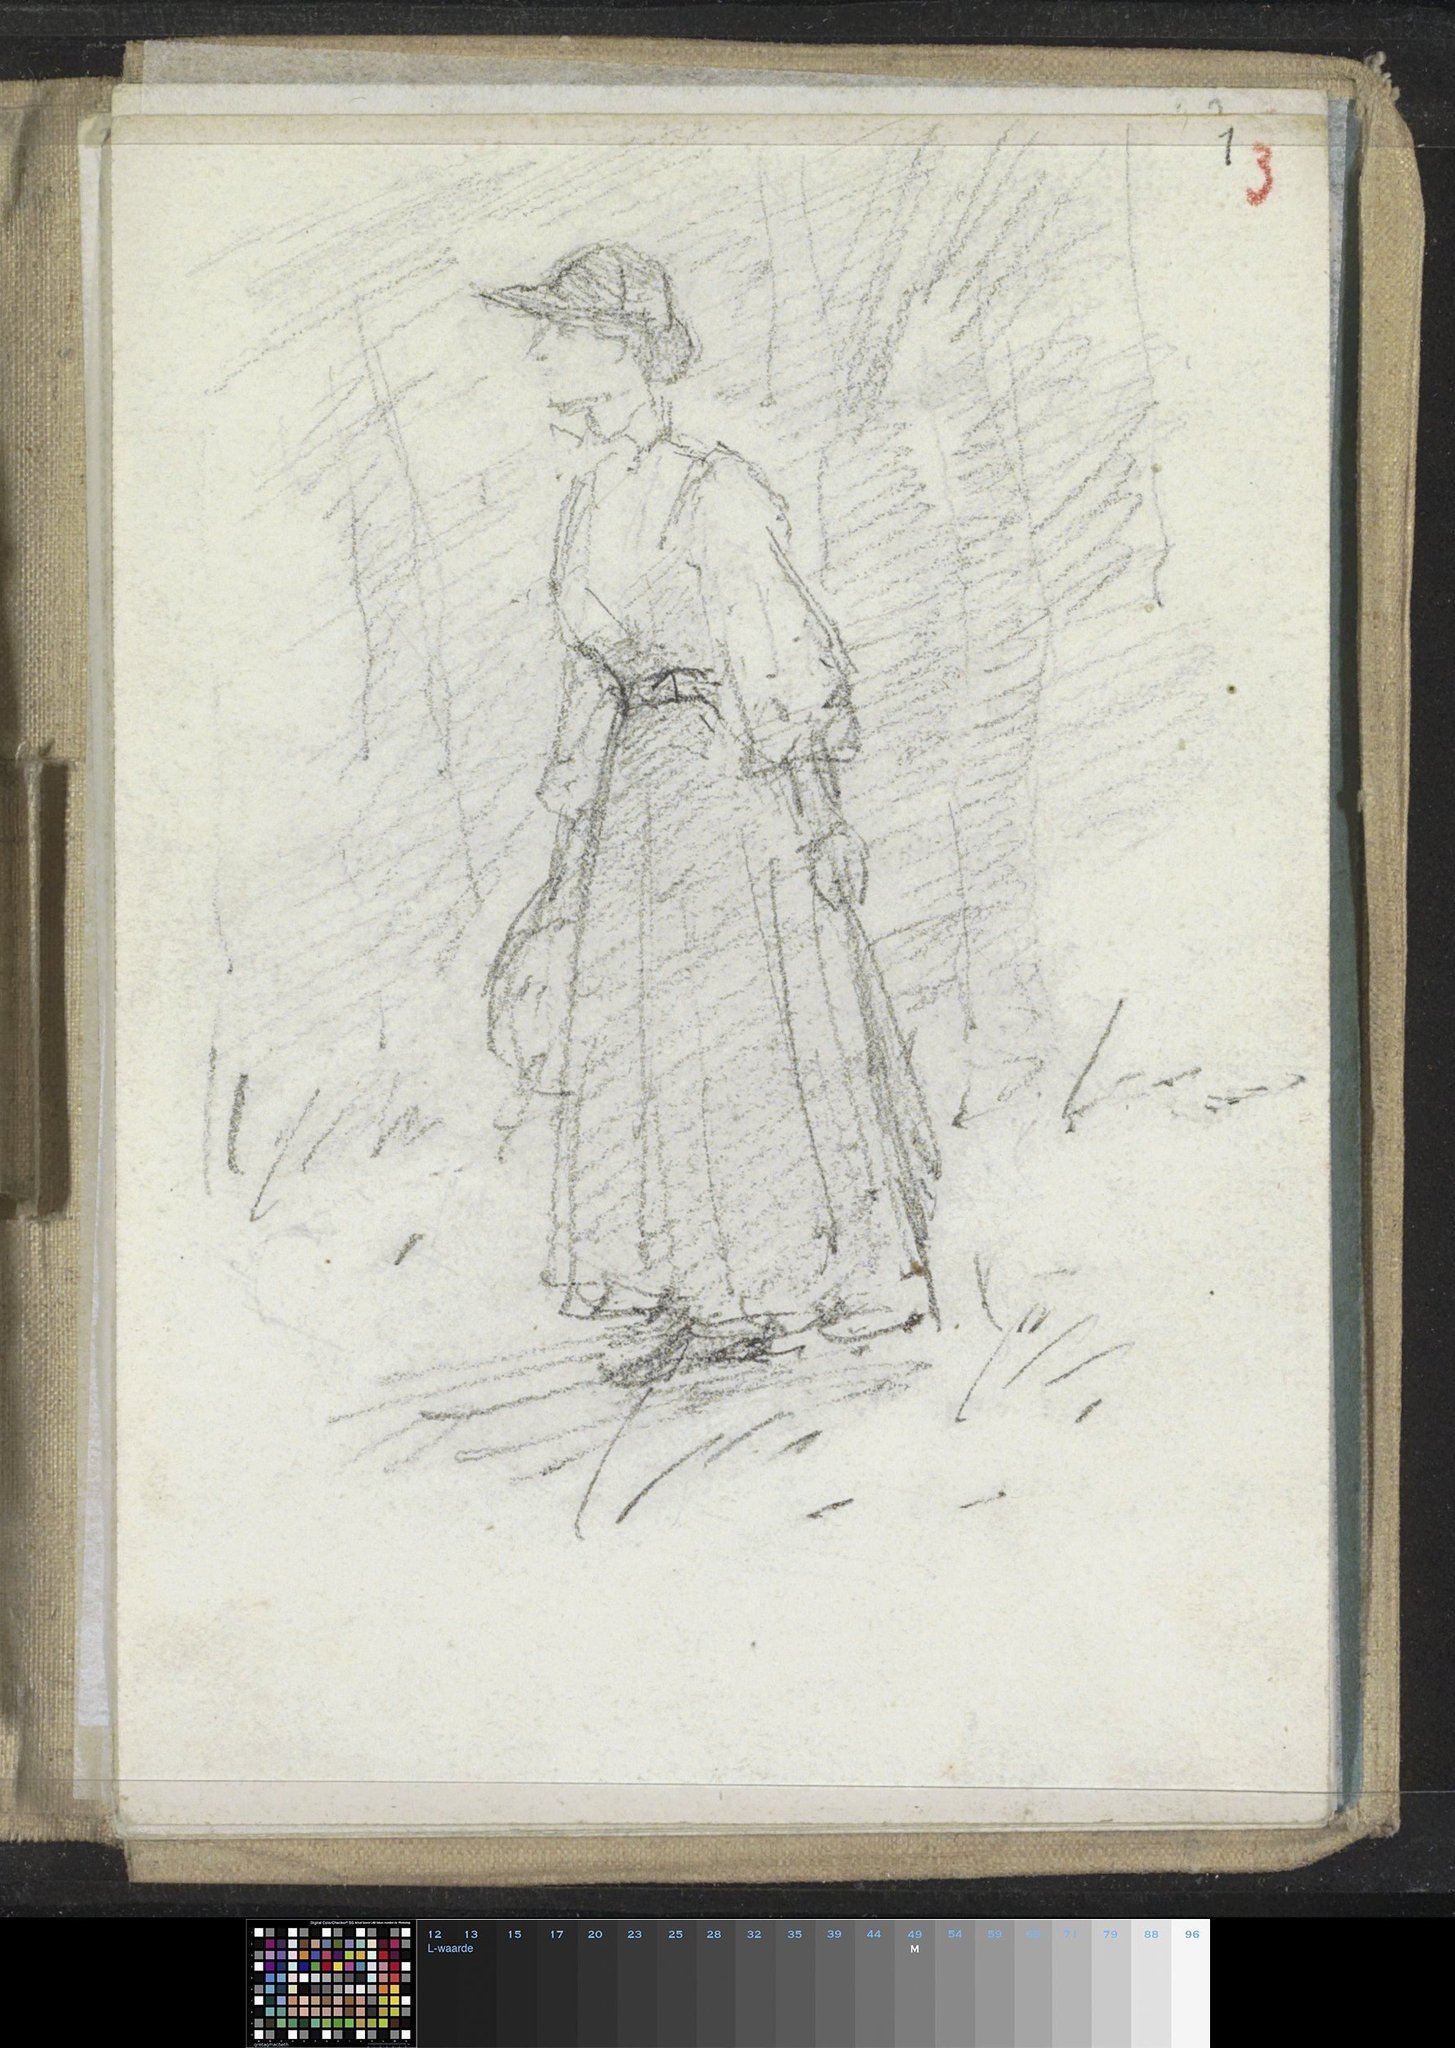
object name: sketchbook leaf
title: Lopende vrouw op een pad langs een rij bomen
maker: jozef israëls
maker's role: draughtsman, painter, print maker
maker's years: 1824-1911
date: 1834-1911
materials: paper, pencil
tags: walking (+ female (human being) (not to be used where -aa- is prescribed)), road, path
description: De vrouw draagt een pet, blouse en lange rok en heeft een tas in de hand. Pagina 1 uit een omslag van een schetsboek met 7 losse bladen.